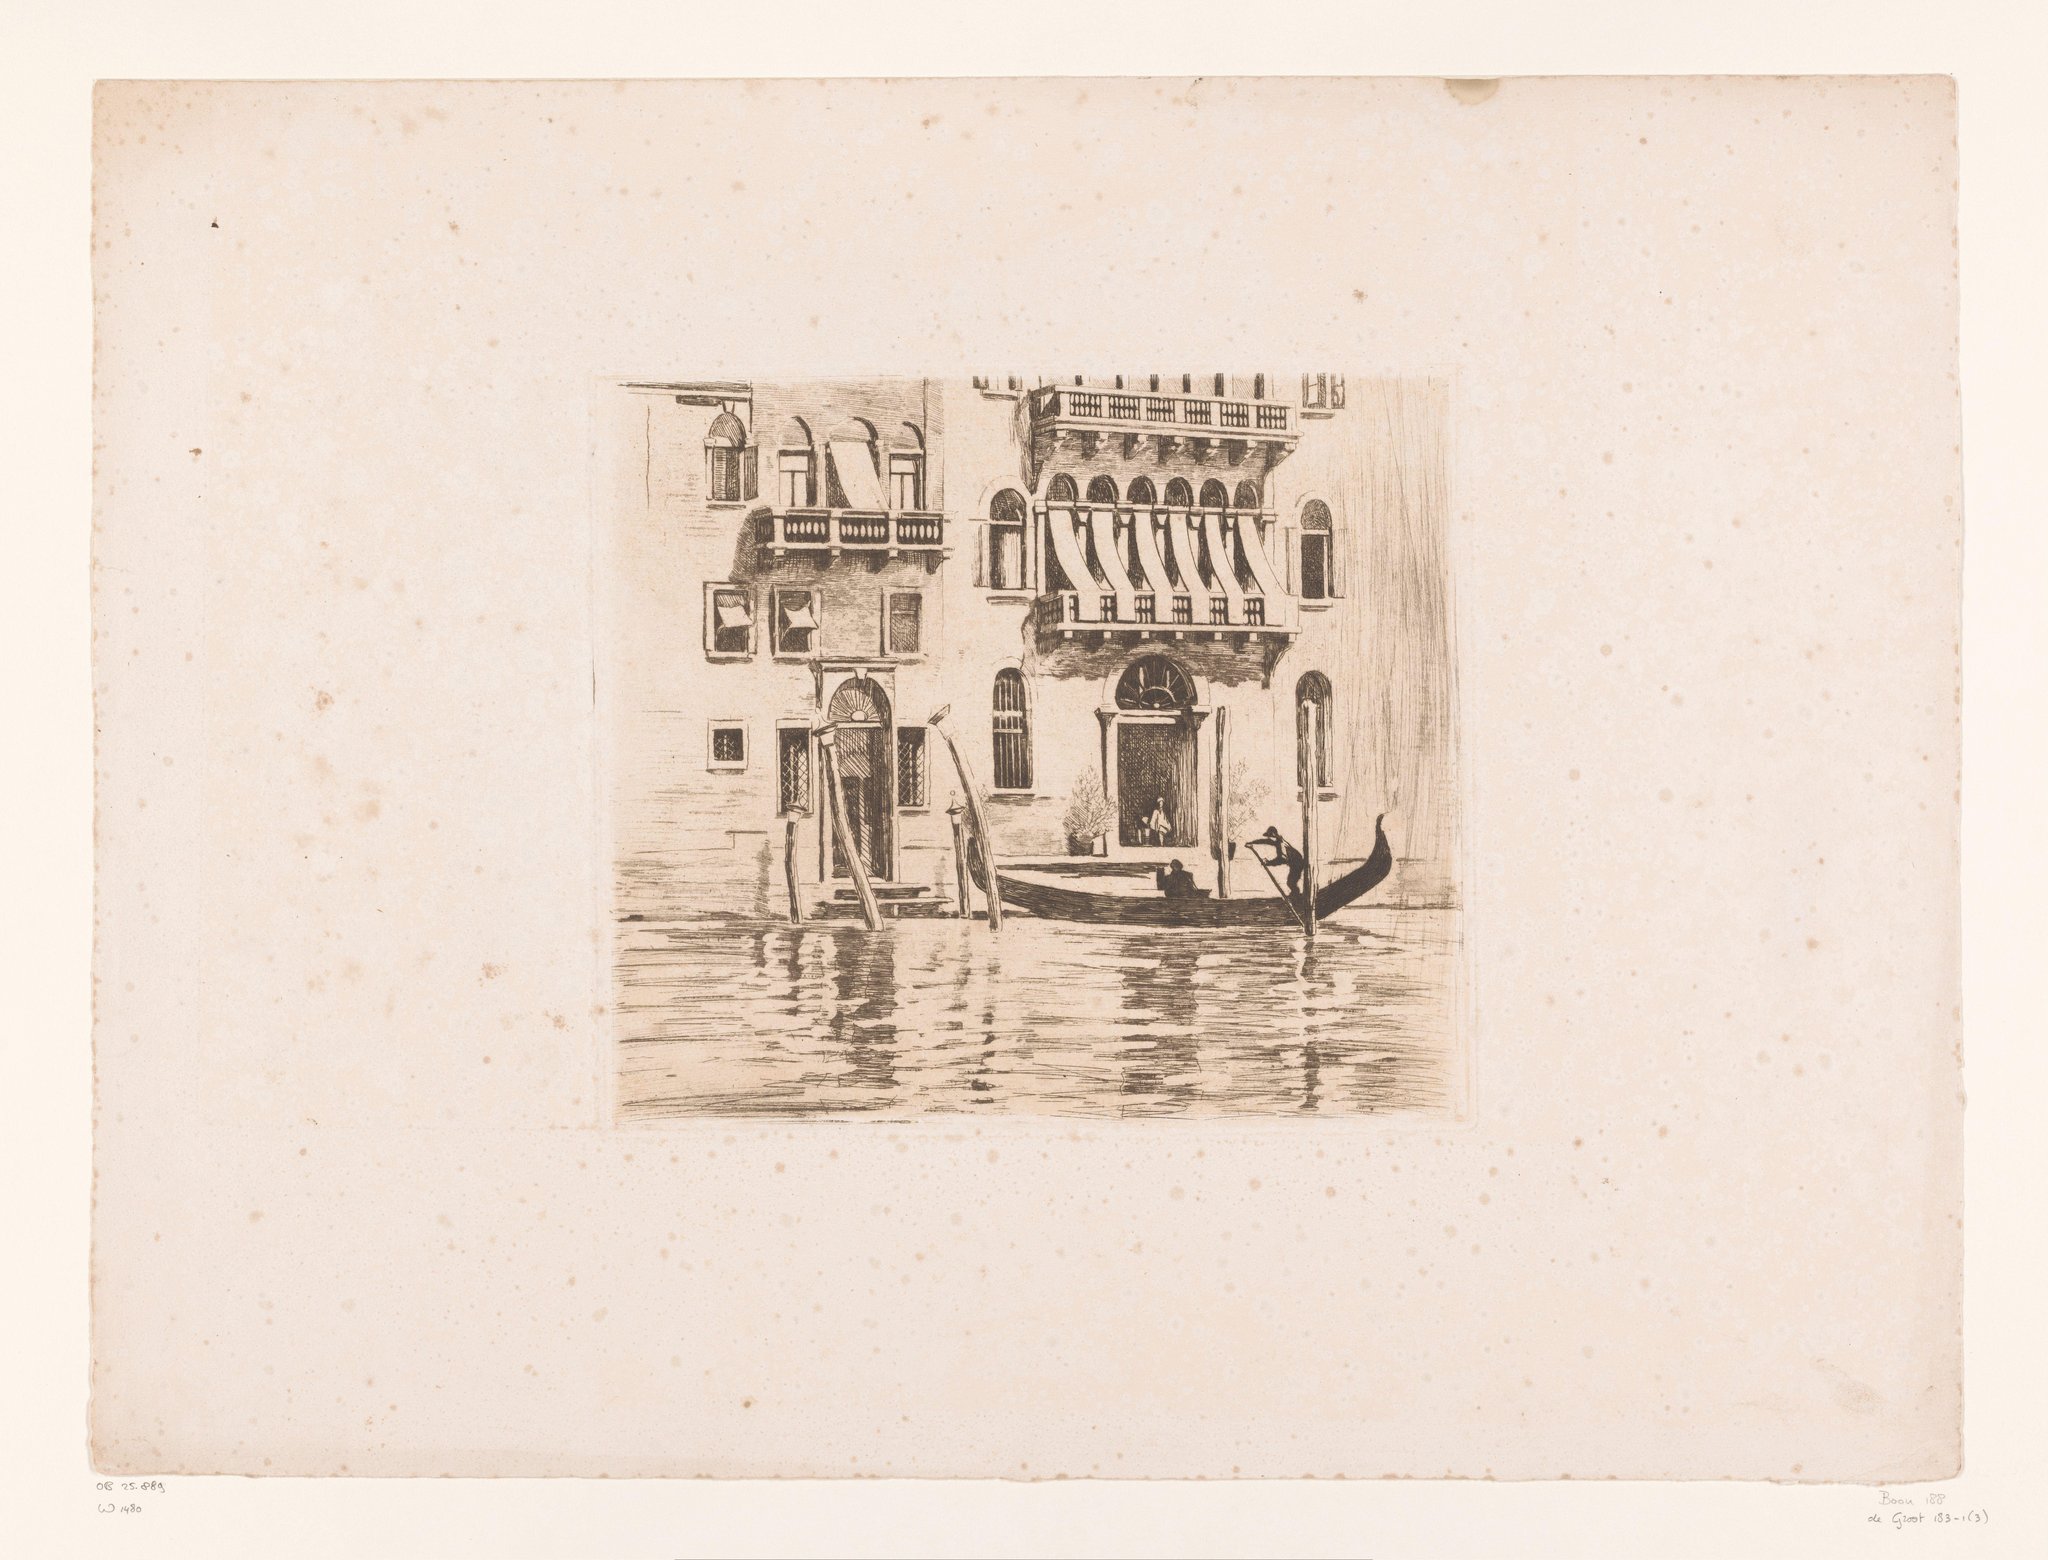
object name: print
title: Huizen met zonwering over de balkons aan het Canal Grande, Venetië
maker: willem witsen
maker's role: draughtsman, painter, print maker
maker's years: 1860-1923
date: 1914-1919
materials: paper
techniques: etching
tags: canals, waters (in city), gondola, venice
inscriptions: annotation: ‘14a/ 14-7-'78 [in getekende driehoek]’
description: Is naar alle waarschijnlijkheid gebaseerd op de Palazzi Businelli en Lanfranchi aan de San Polo-zijde van het Canal Grande.